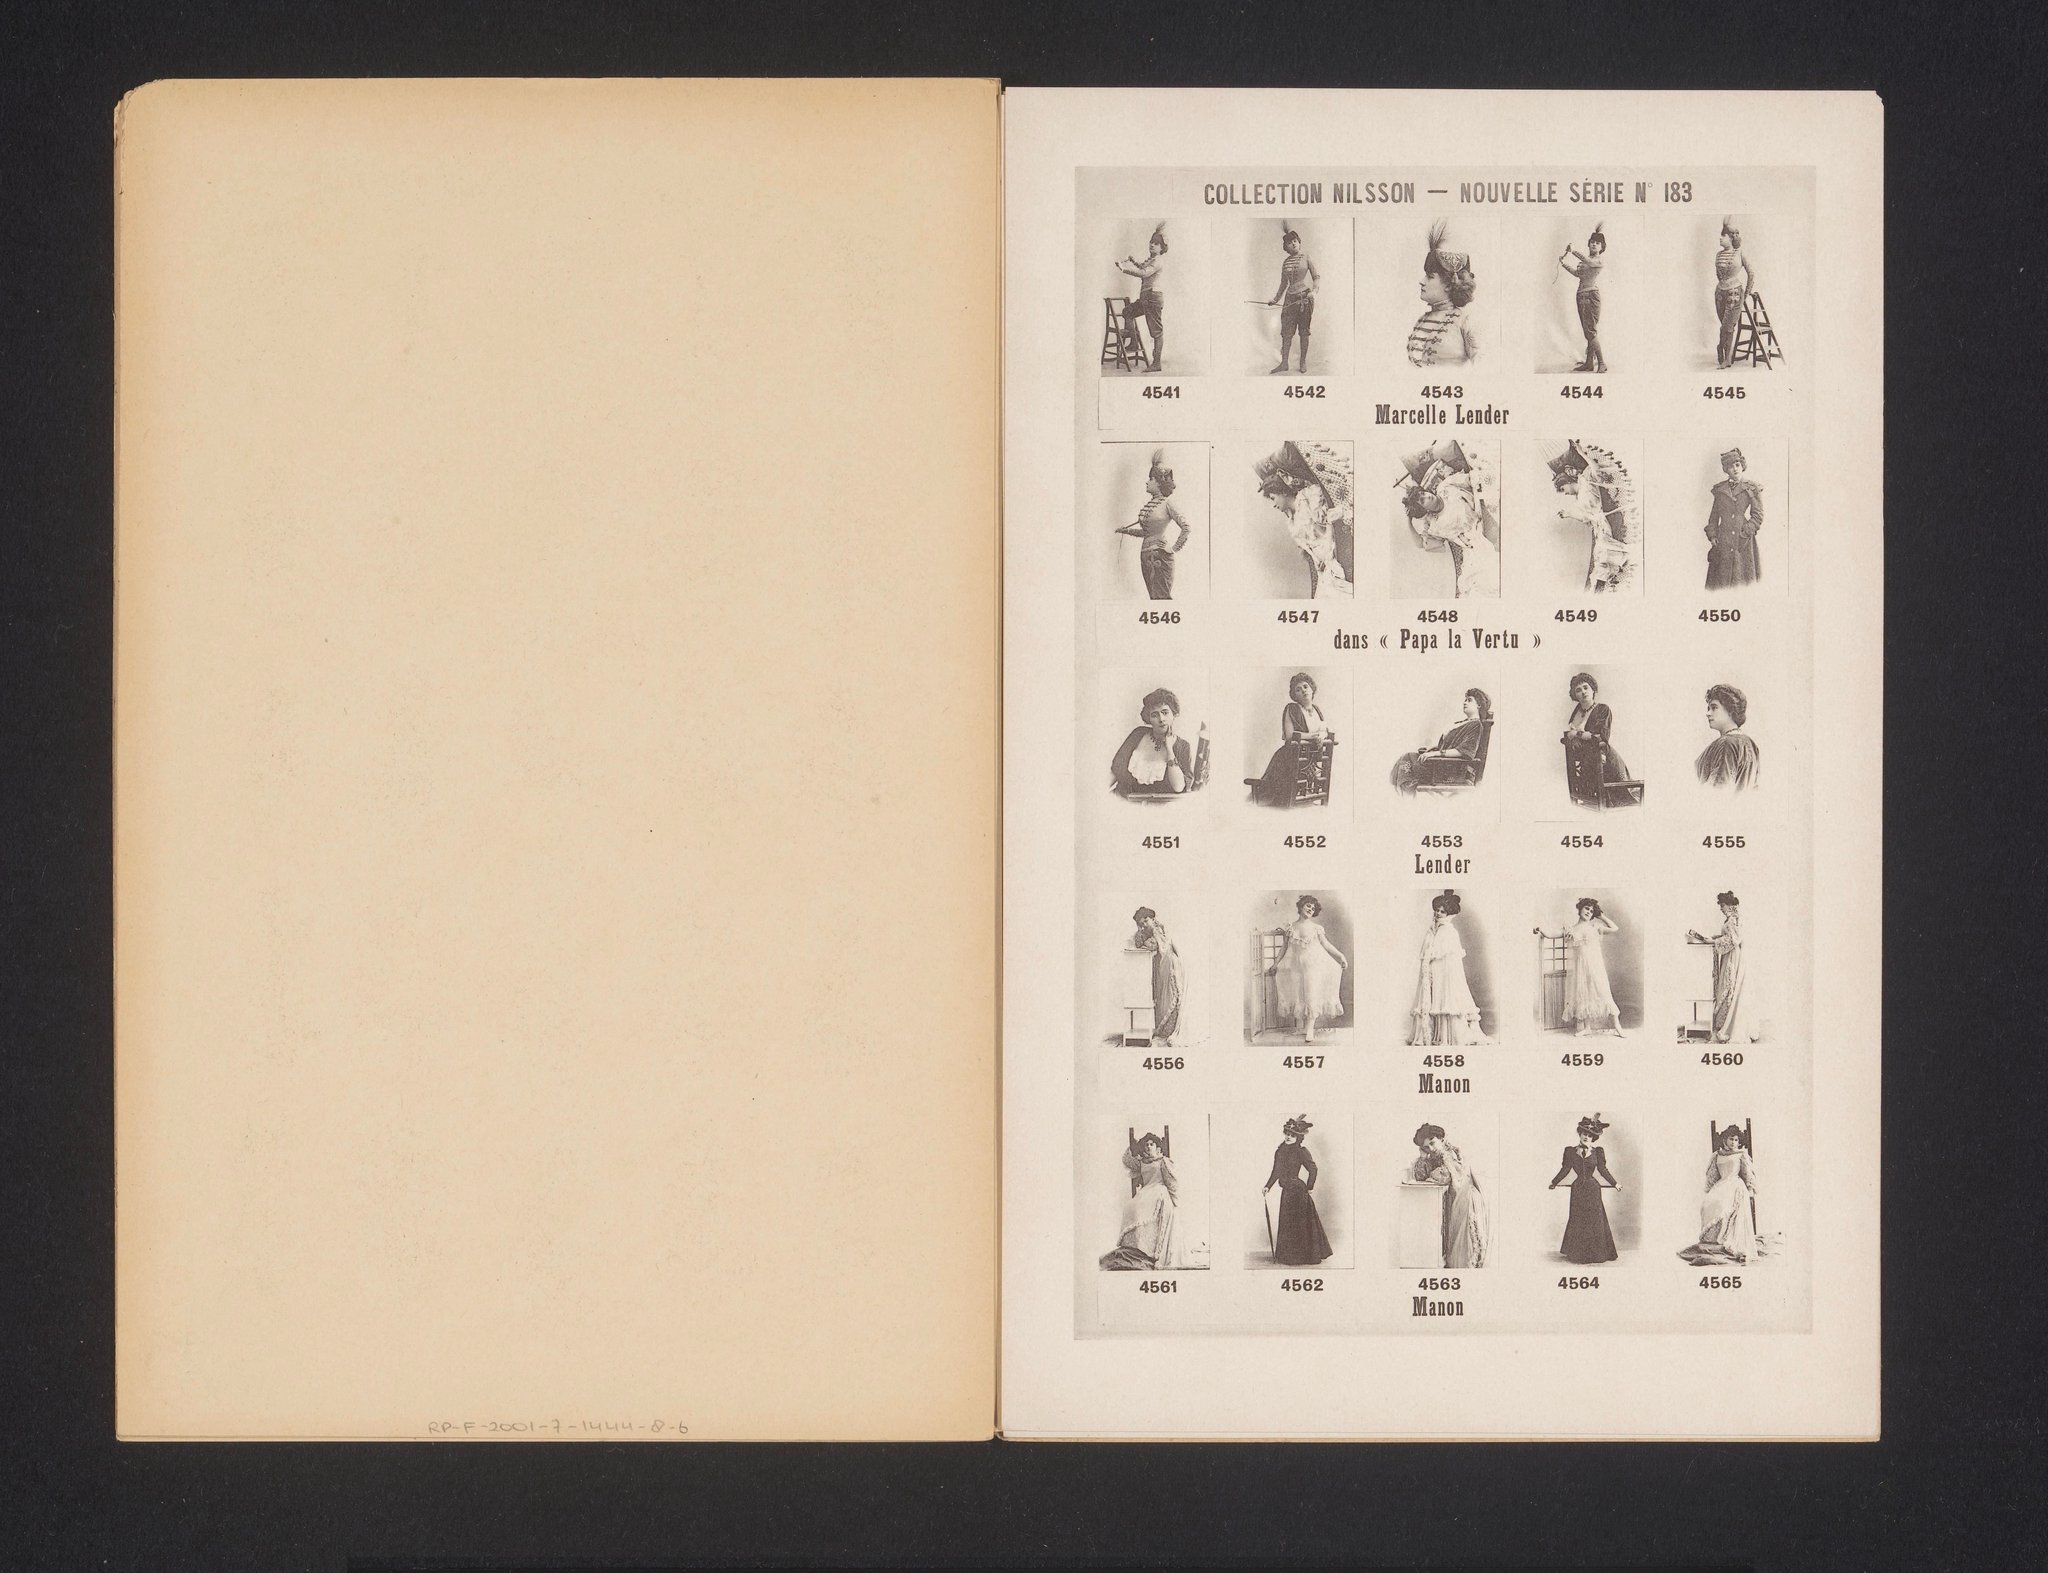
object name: photomechanical print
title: 25 portretten van Marcelle Lender en Manon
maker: Anonymous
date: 1894-1899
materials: paper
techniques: photograph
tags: historical persons - bb - woman, portrait of actor, actress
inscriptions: number: ‘No 183’, inscription: ‘Marcelle Lender/ dans < < Papa la Vertu > >/ Lender/ Manon/ Manon’